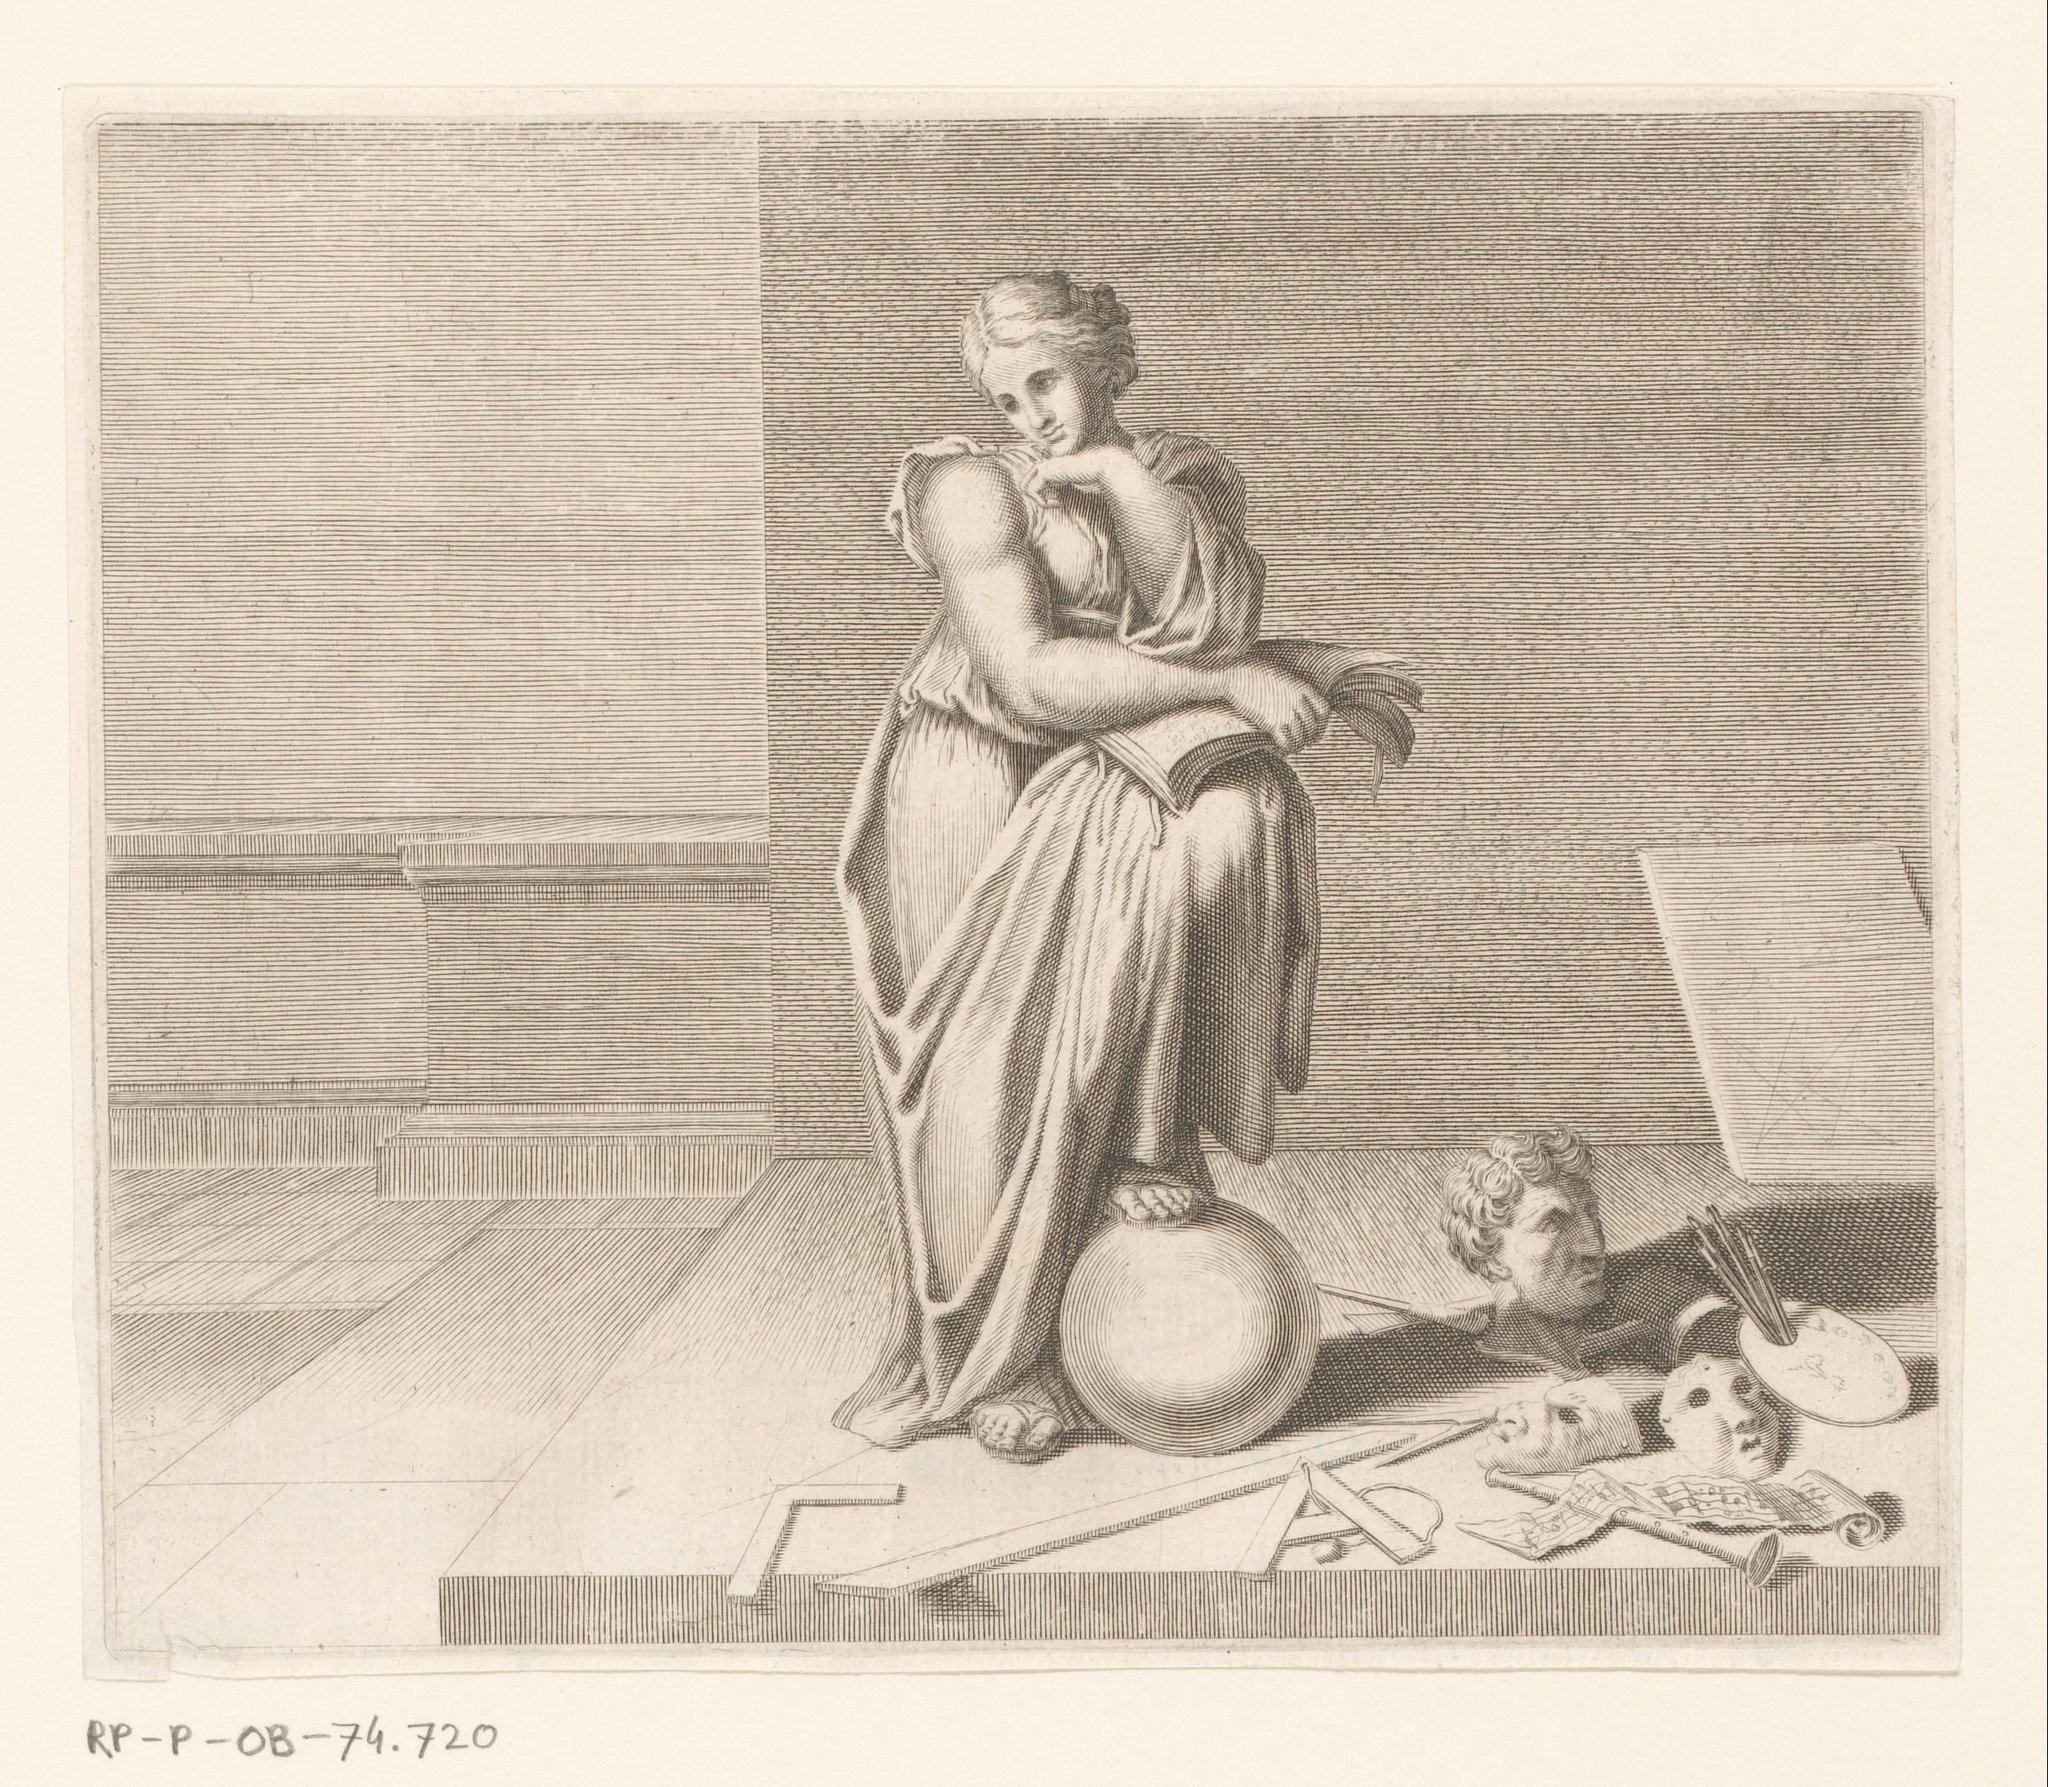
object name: print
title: Vrouw met haar voet leunend op bol waarnaast attributen van de kunsten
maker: Anonymous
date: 1600-1699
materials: paper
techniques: engraving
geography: france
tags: mask, the arts; artists, palette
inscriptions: collector's mark: Lugt 2228